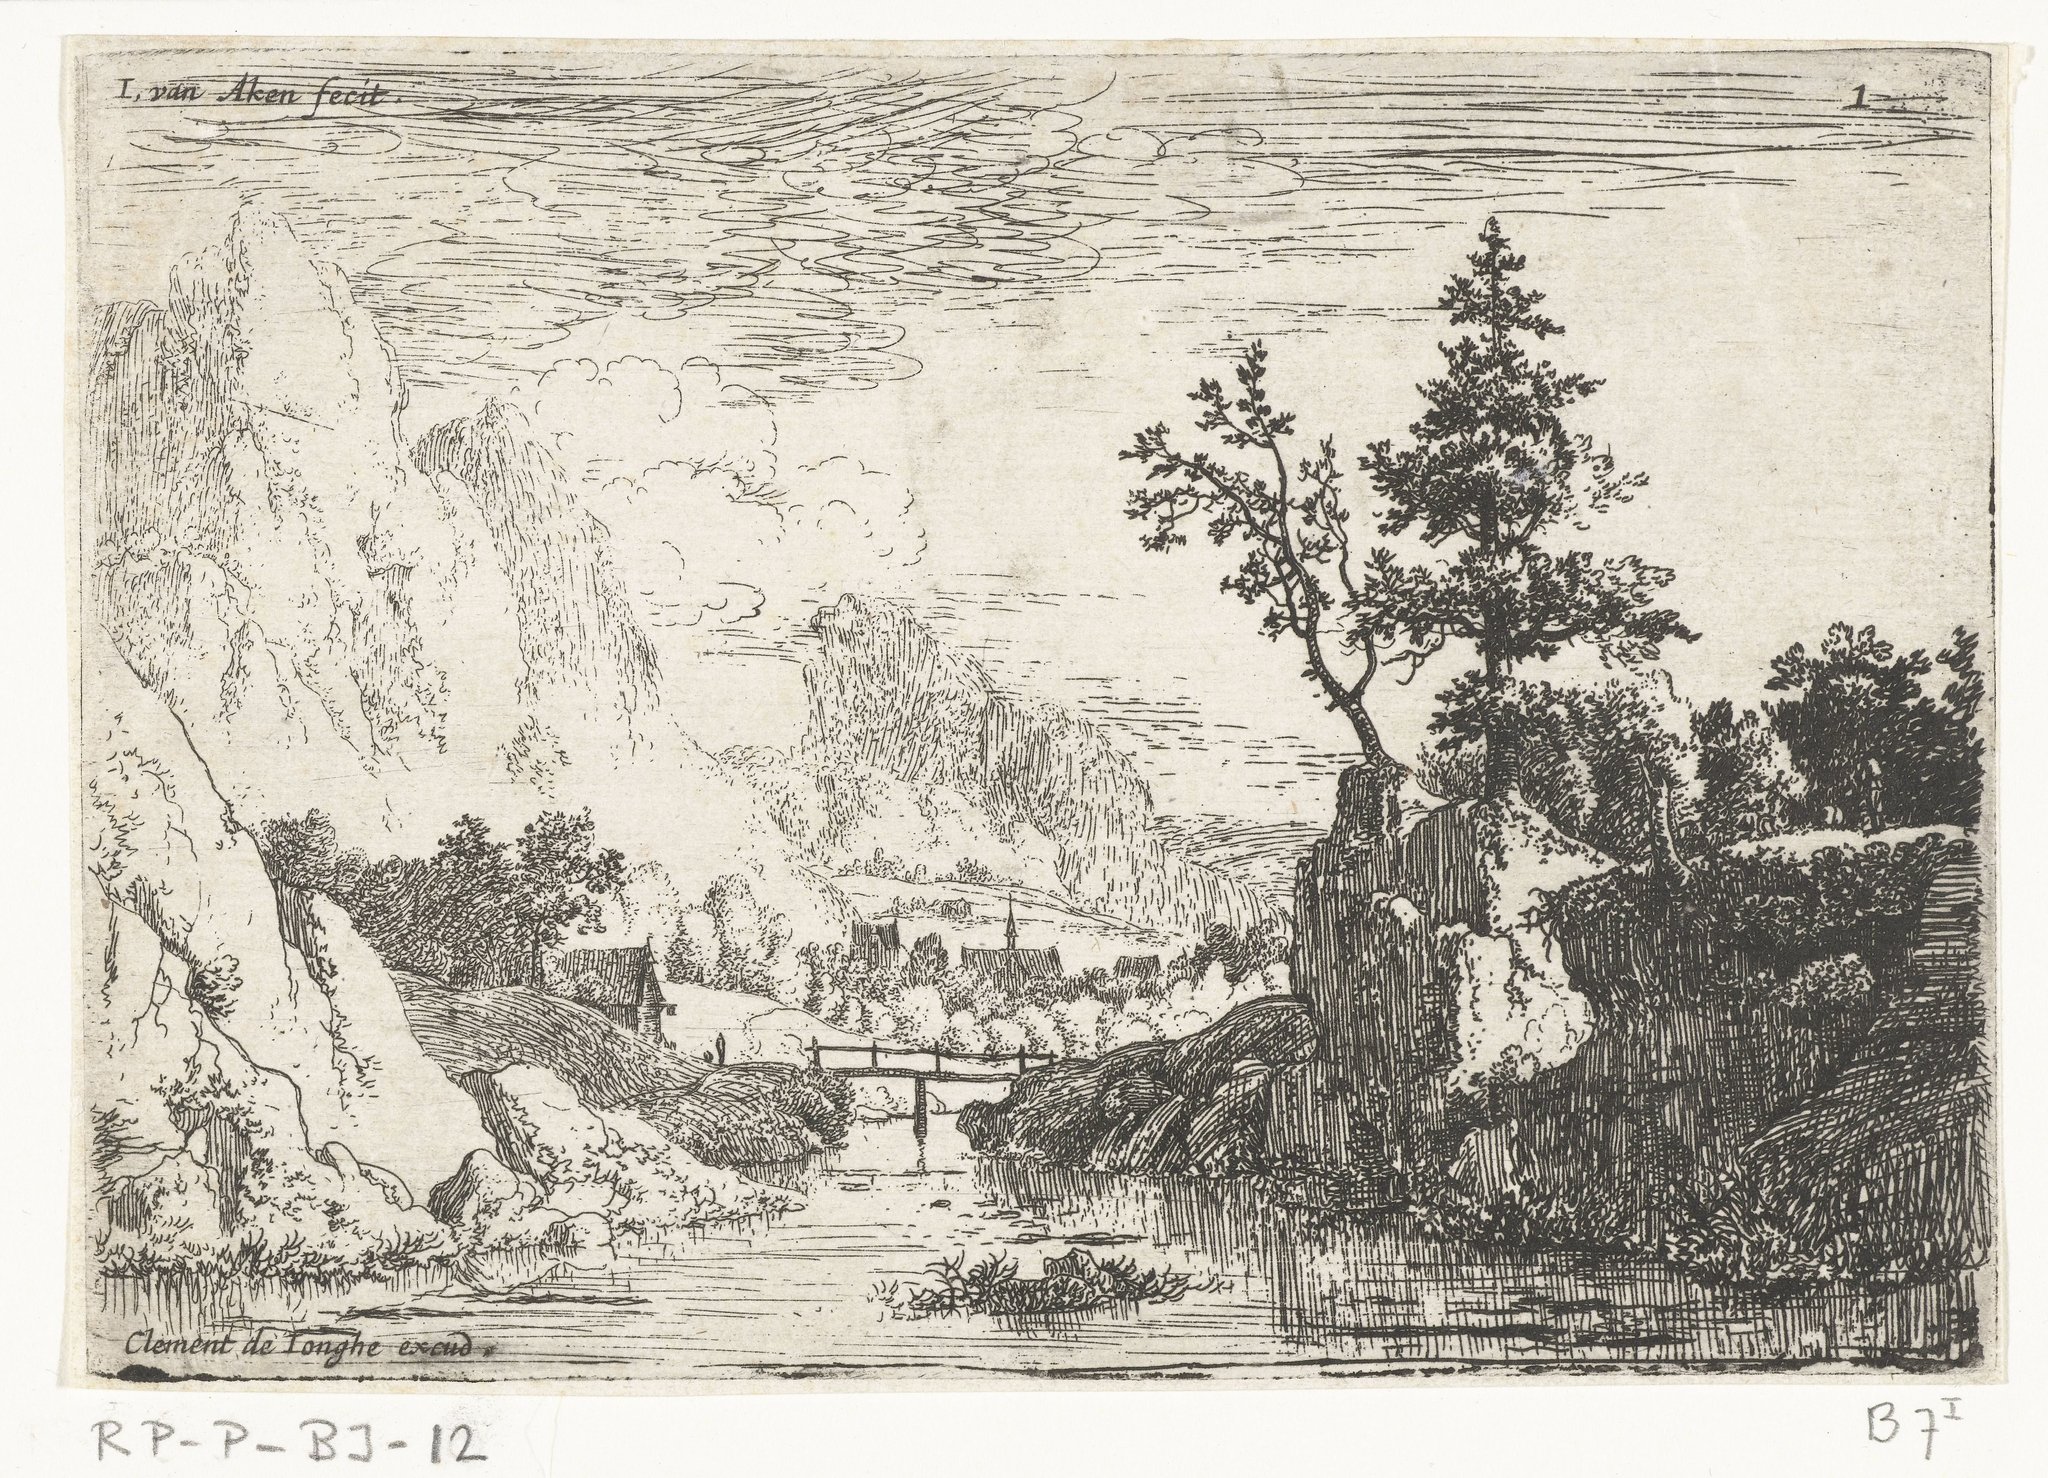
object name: print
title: Tien landschappen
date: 1624-1661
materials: paper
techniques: etching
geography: amsterdam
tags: landscapes with waters, waterscapes, seascapes (in the temperate zone)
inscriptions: collector's mark: Lugt 240